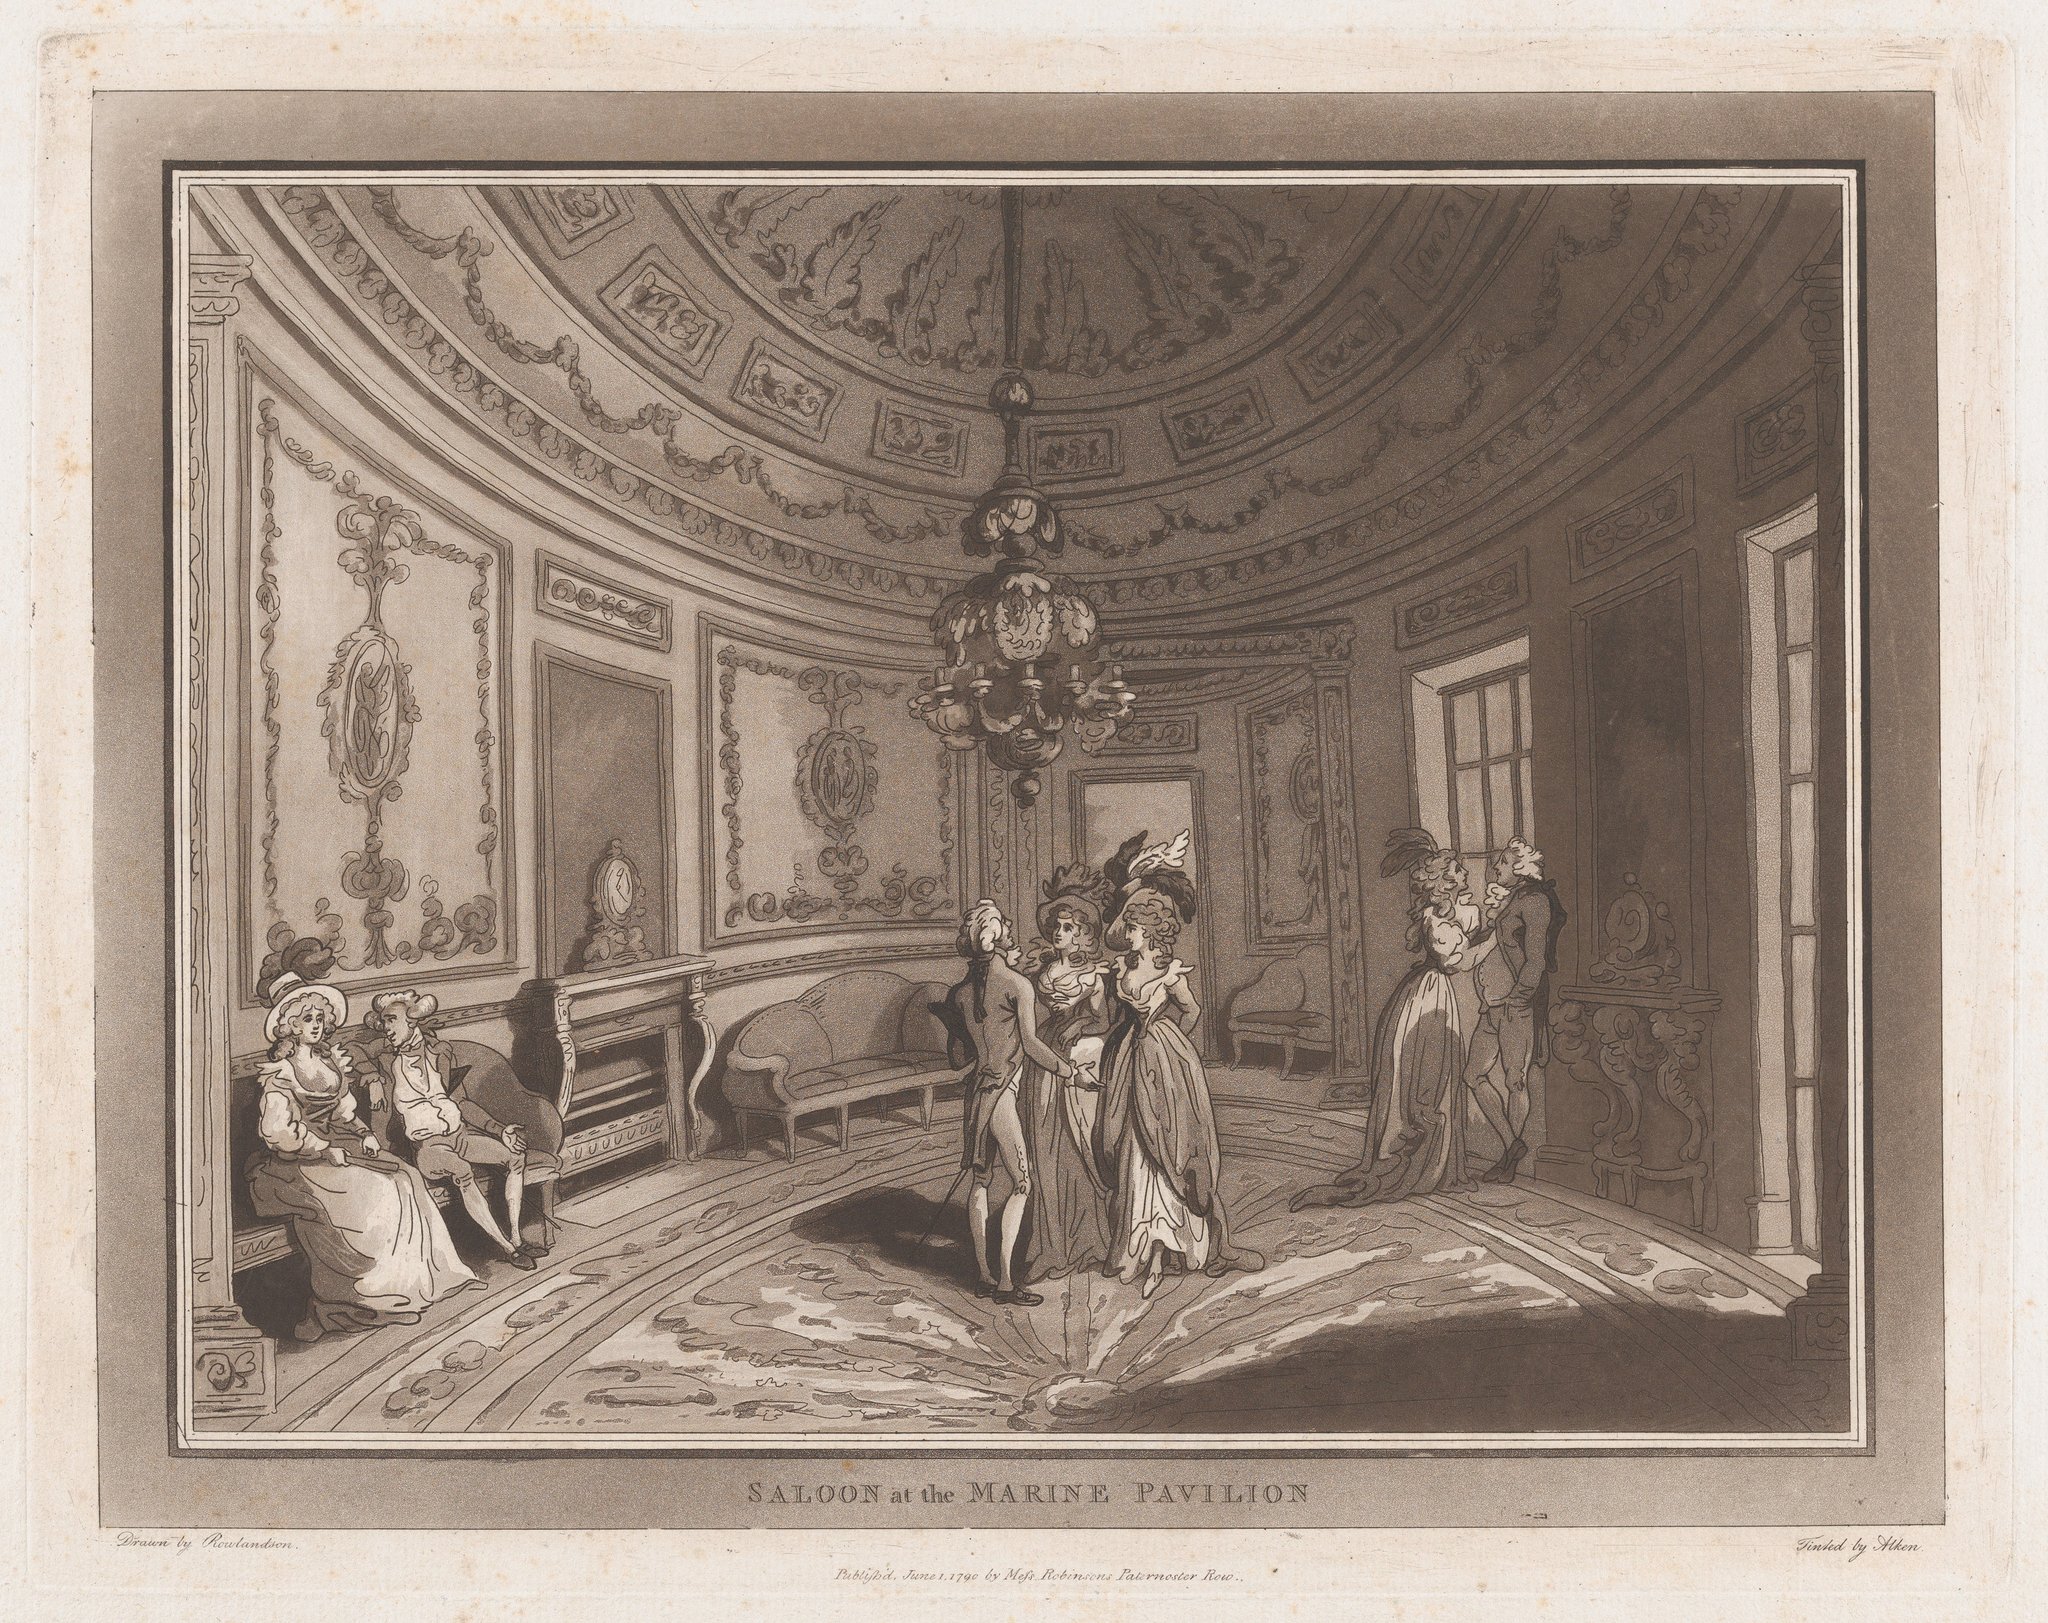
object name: print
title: Saloon at the Marine Pavillion (An Excursion to Brighthelmstone)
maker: thomas rowlandson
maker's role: artist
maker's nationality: british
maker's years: 1757-1827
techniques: aquatint, etching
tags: interiors,men,women